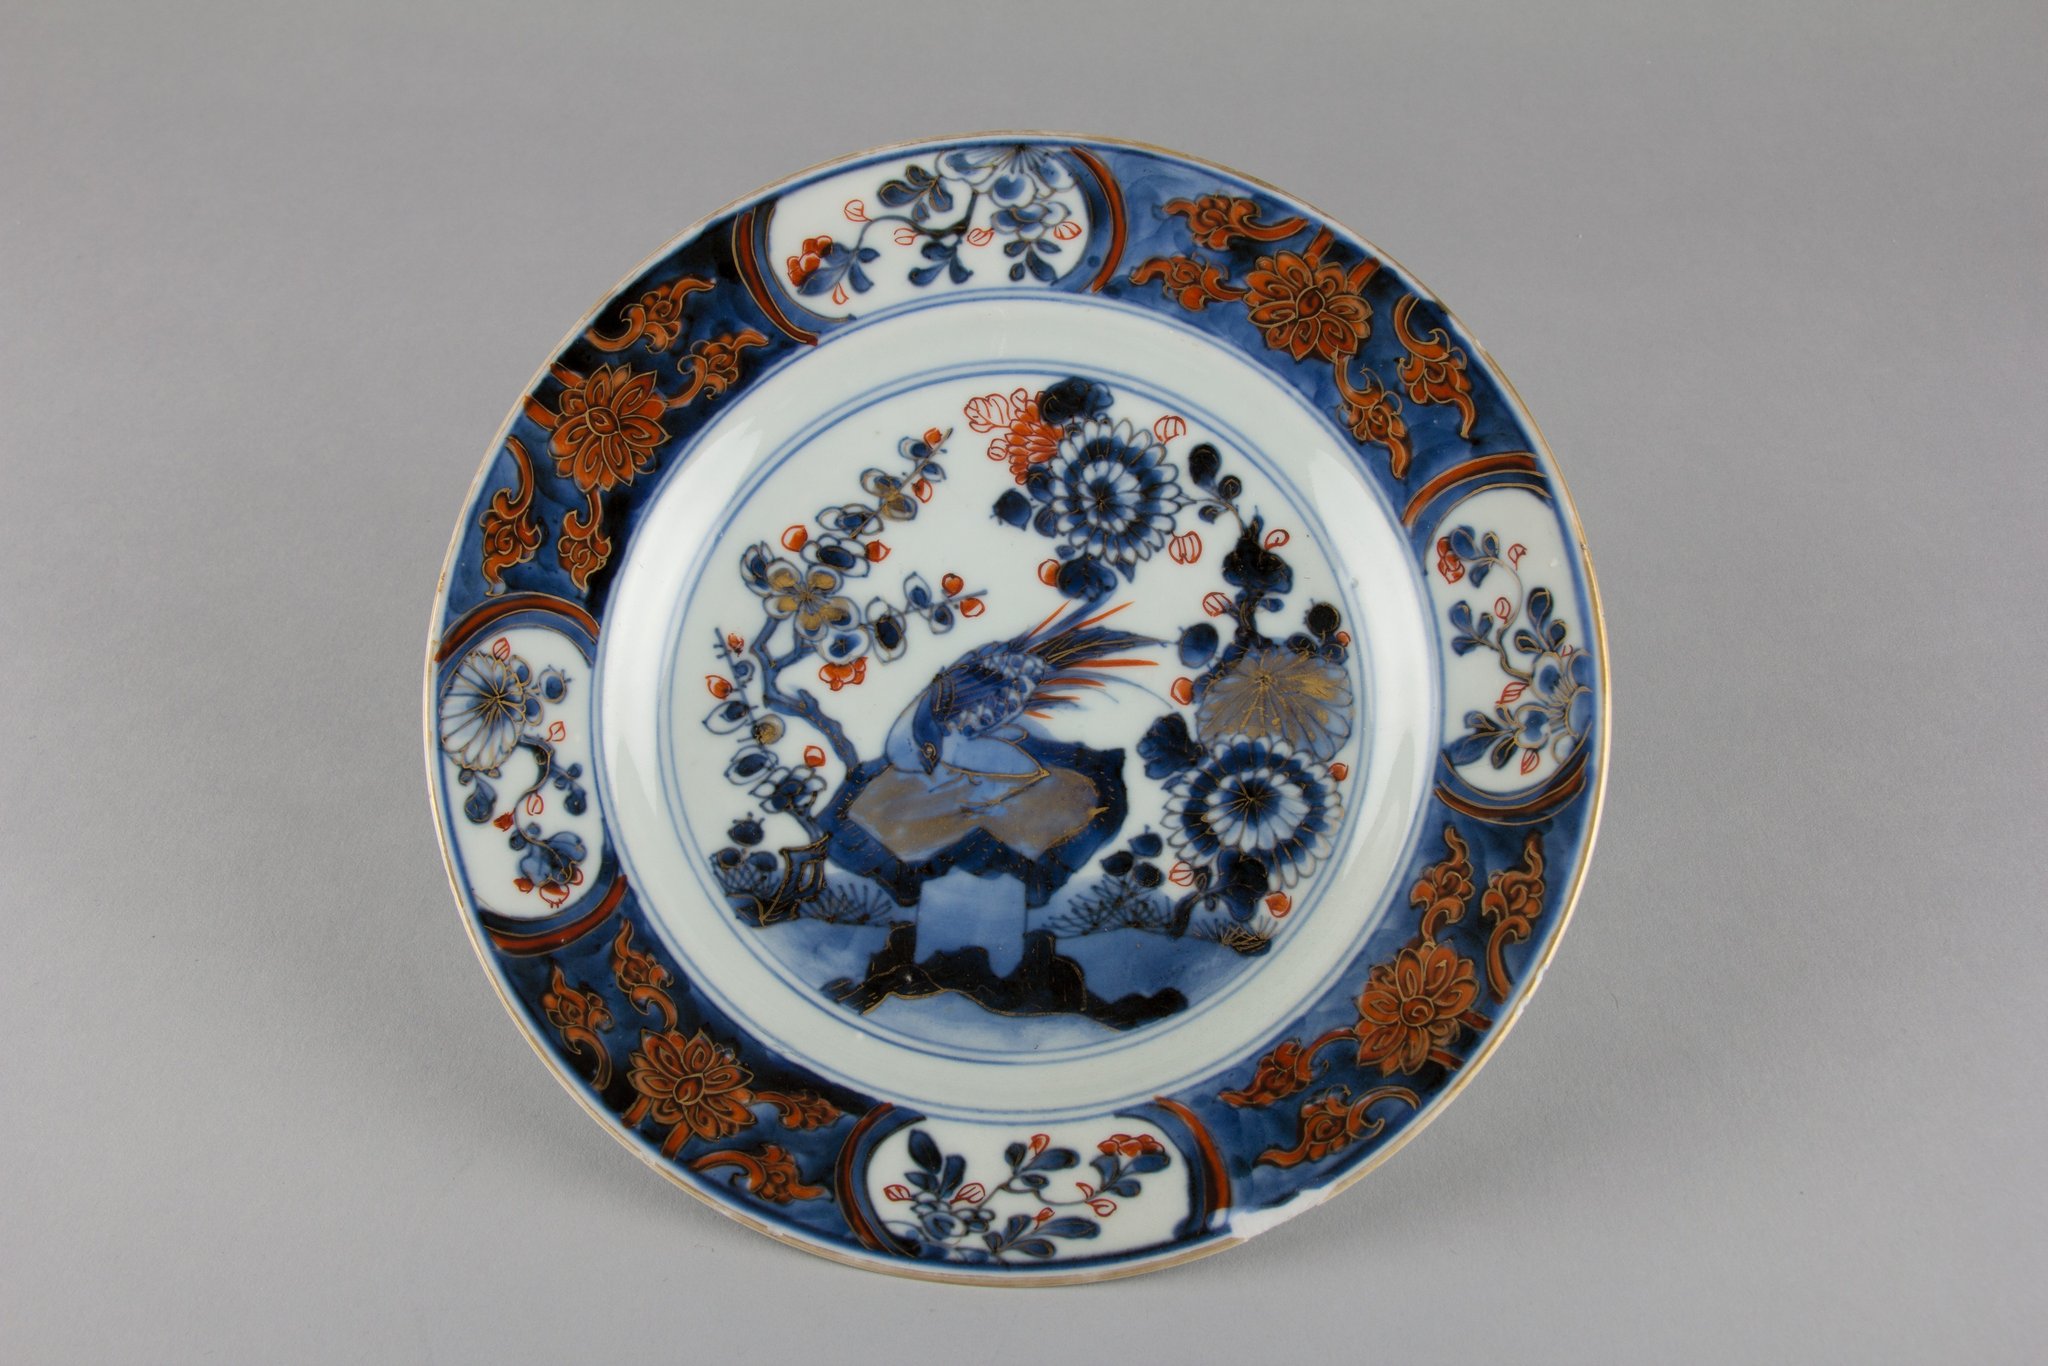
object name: plate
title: Plate with bird and flowers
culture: chinese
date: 1701-1800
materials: iron, porcelain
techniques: overglaze, painting, underglaze